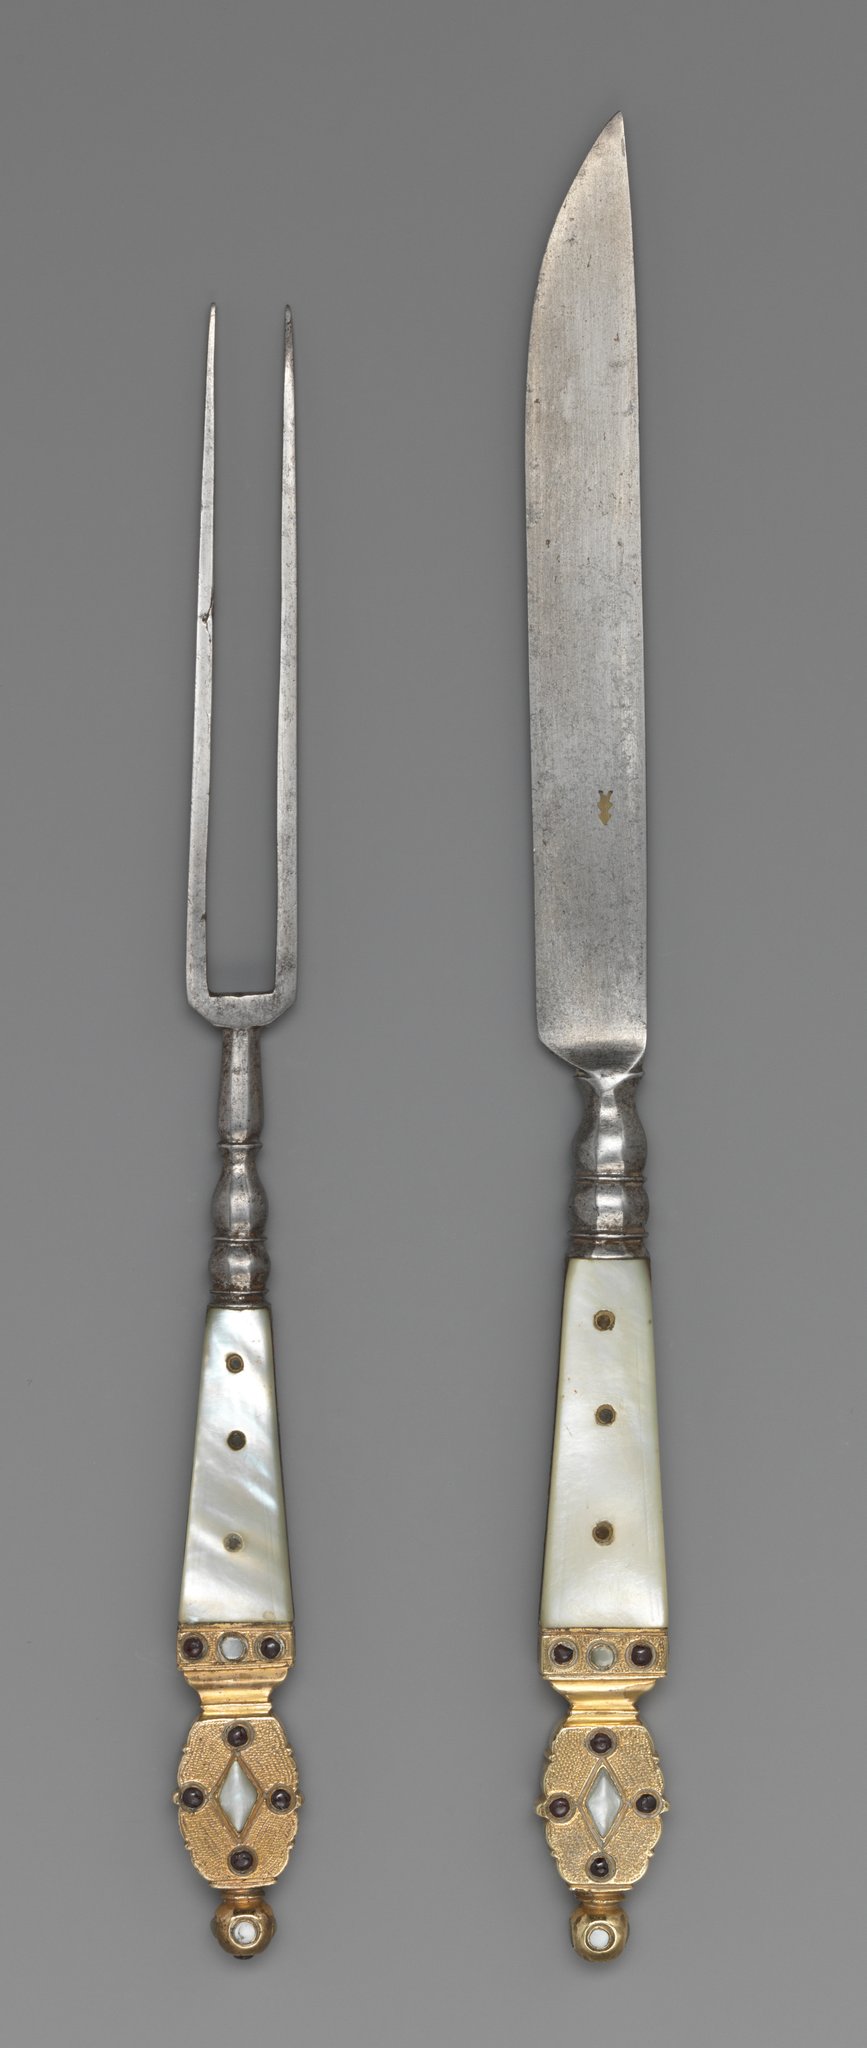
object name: table knife and fork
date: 1667-1700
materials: mother of pearl, paste, steel